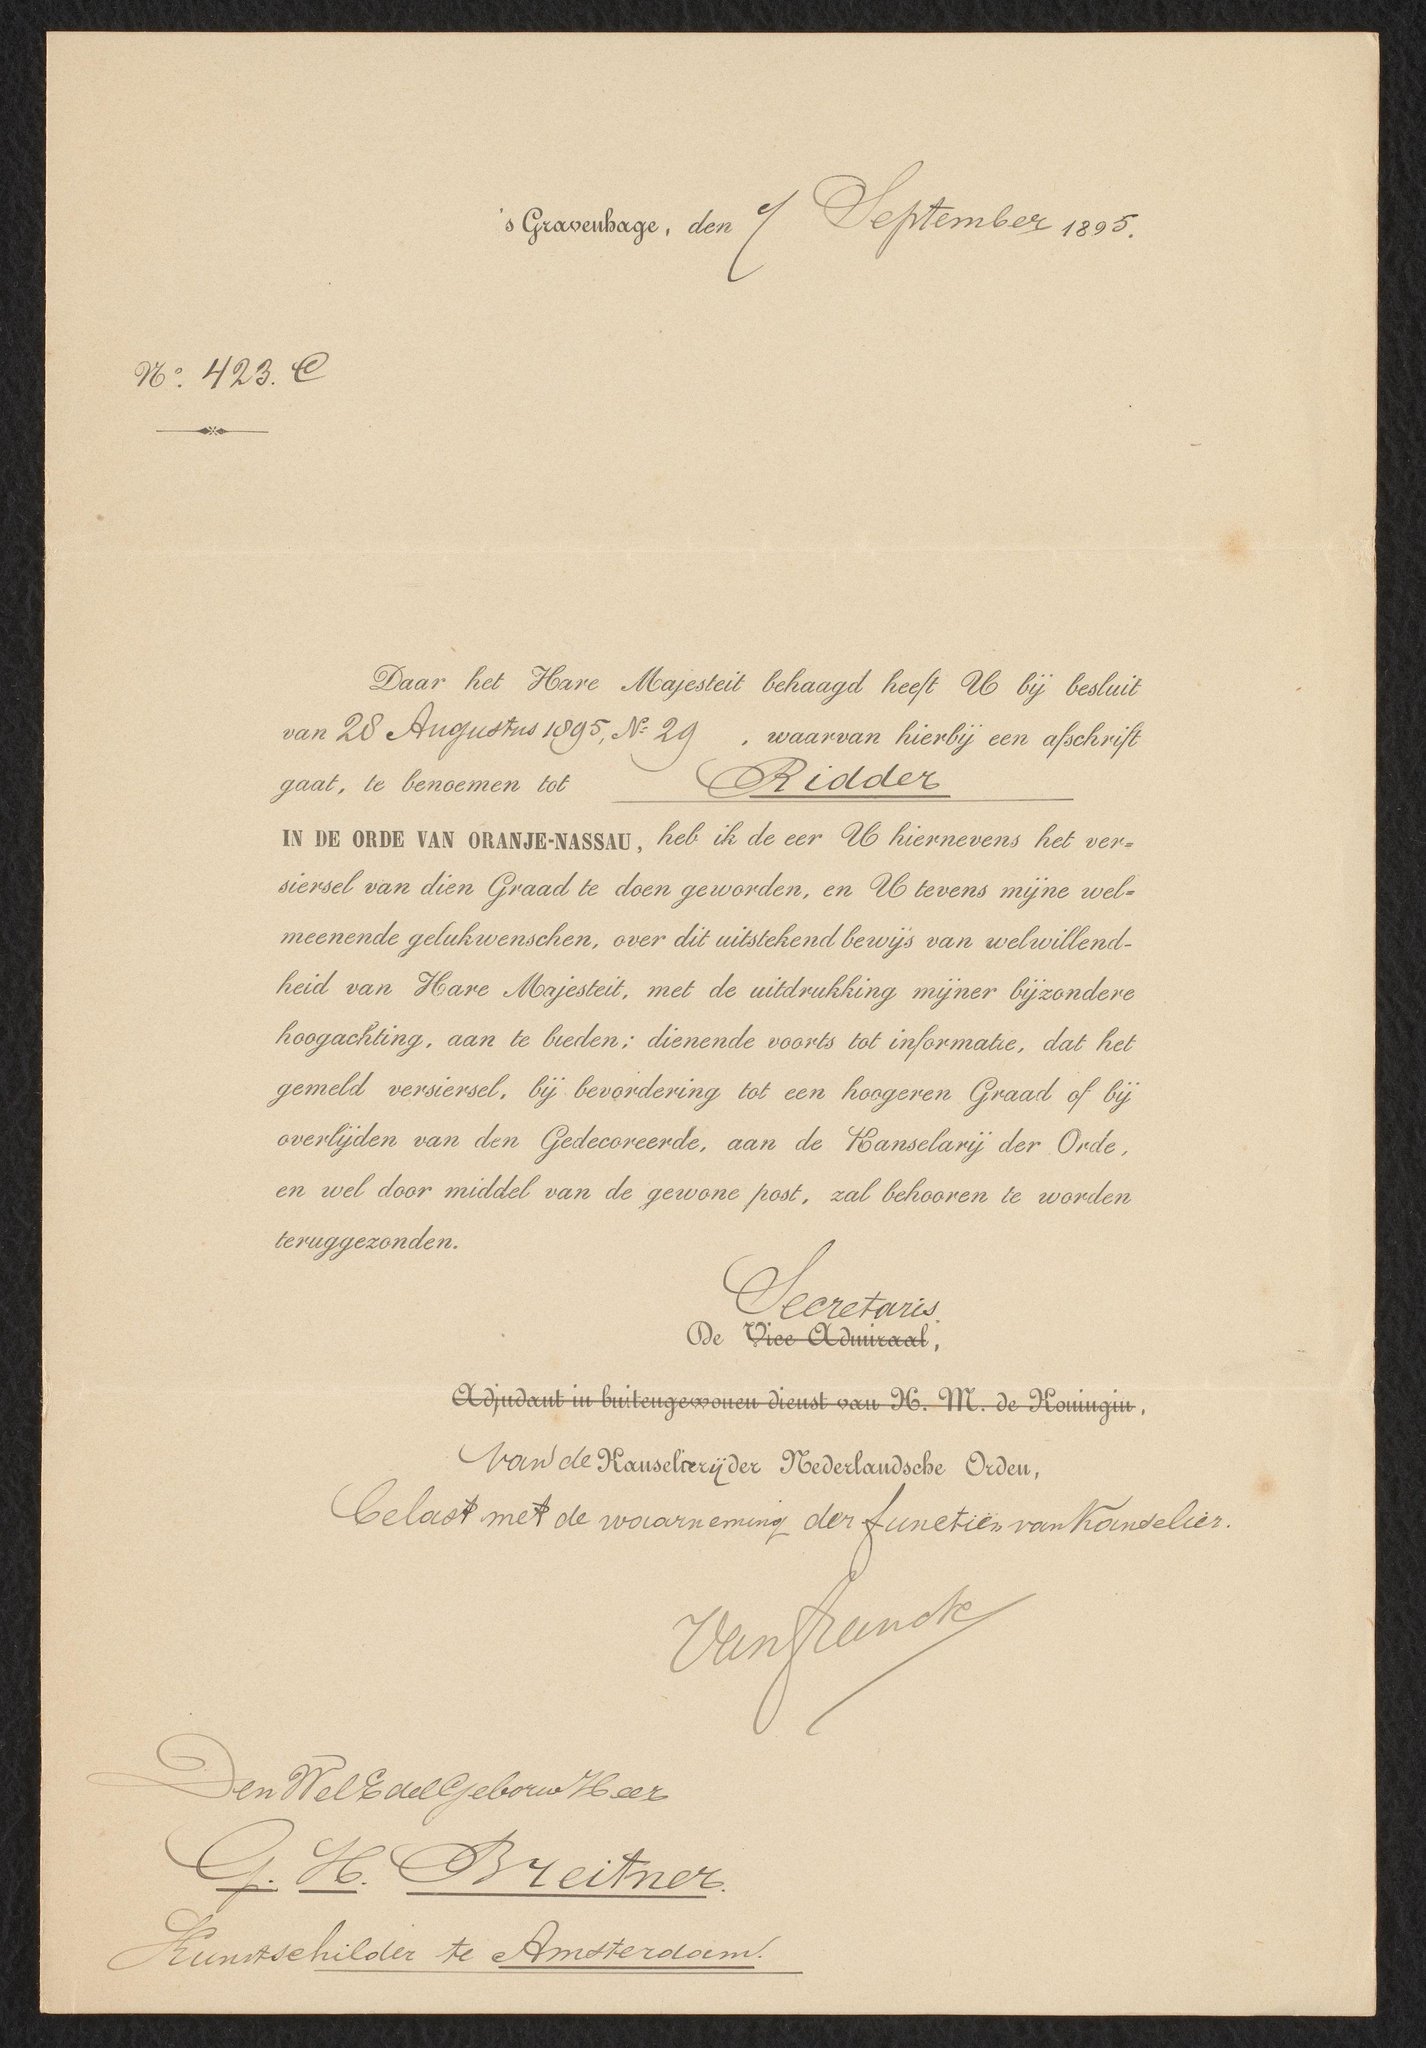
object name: letter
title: Brief gericht aan George Hendrik Breitner, behorende bij het afschrift namens koningin-regentes Emma en koningin Wilhelmina betreffende Breitner's benoeming in de Orde van Oranje-Nassau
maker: Anonymous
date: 1895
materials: ink, paper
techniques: letterpress printing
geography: the hague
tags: amsterdam, painter, print maker, draughtsman, george hendrik breitner, distribution of awards ~ art contest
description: Brief gericht aan George Hendrik Breitner, ondertekend door de secretaris van de Kanselarij der Nederlandsche Orden.